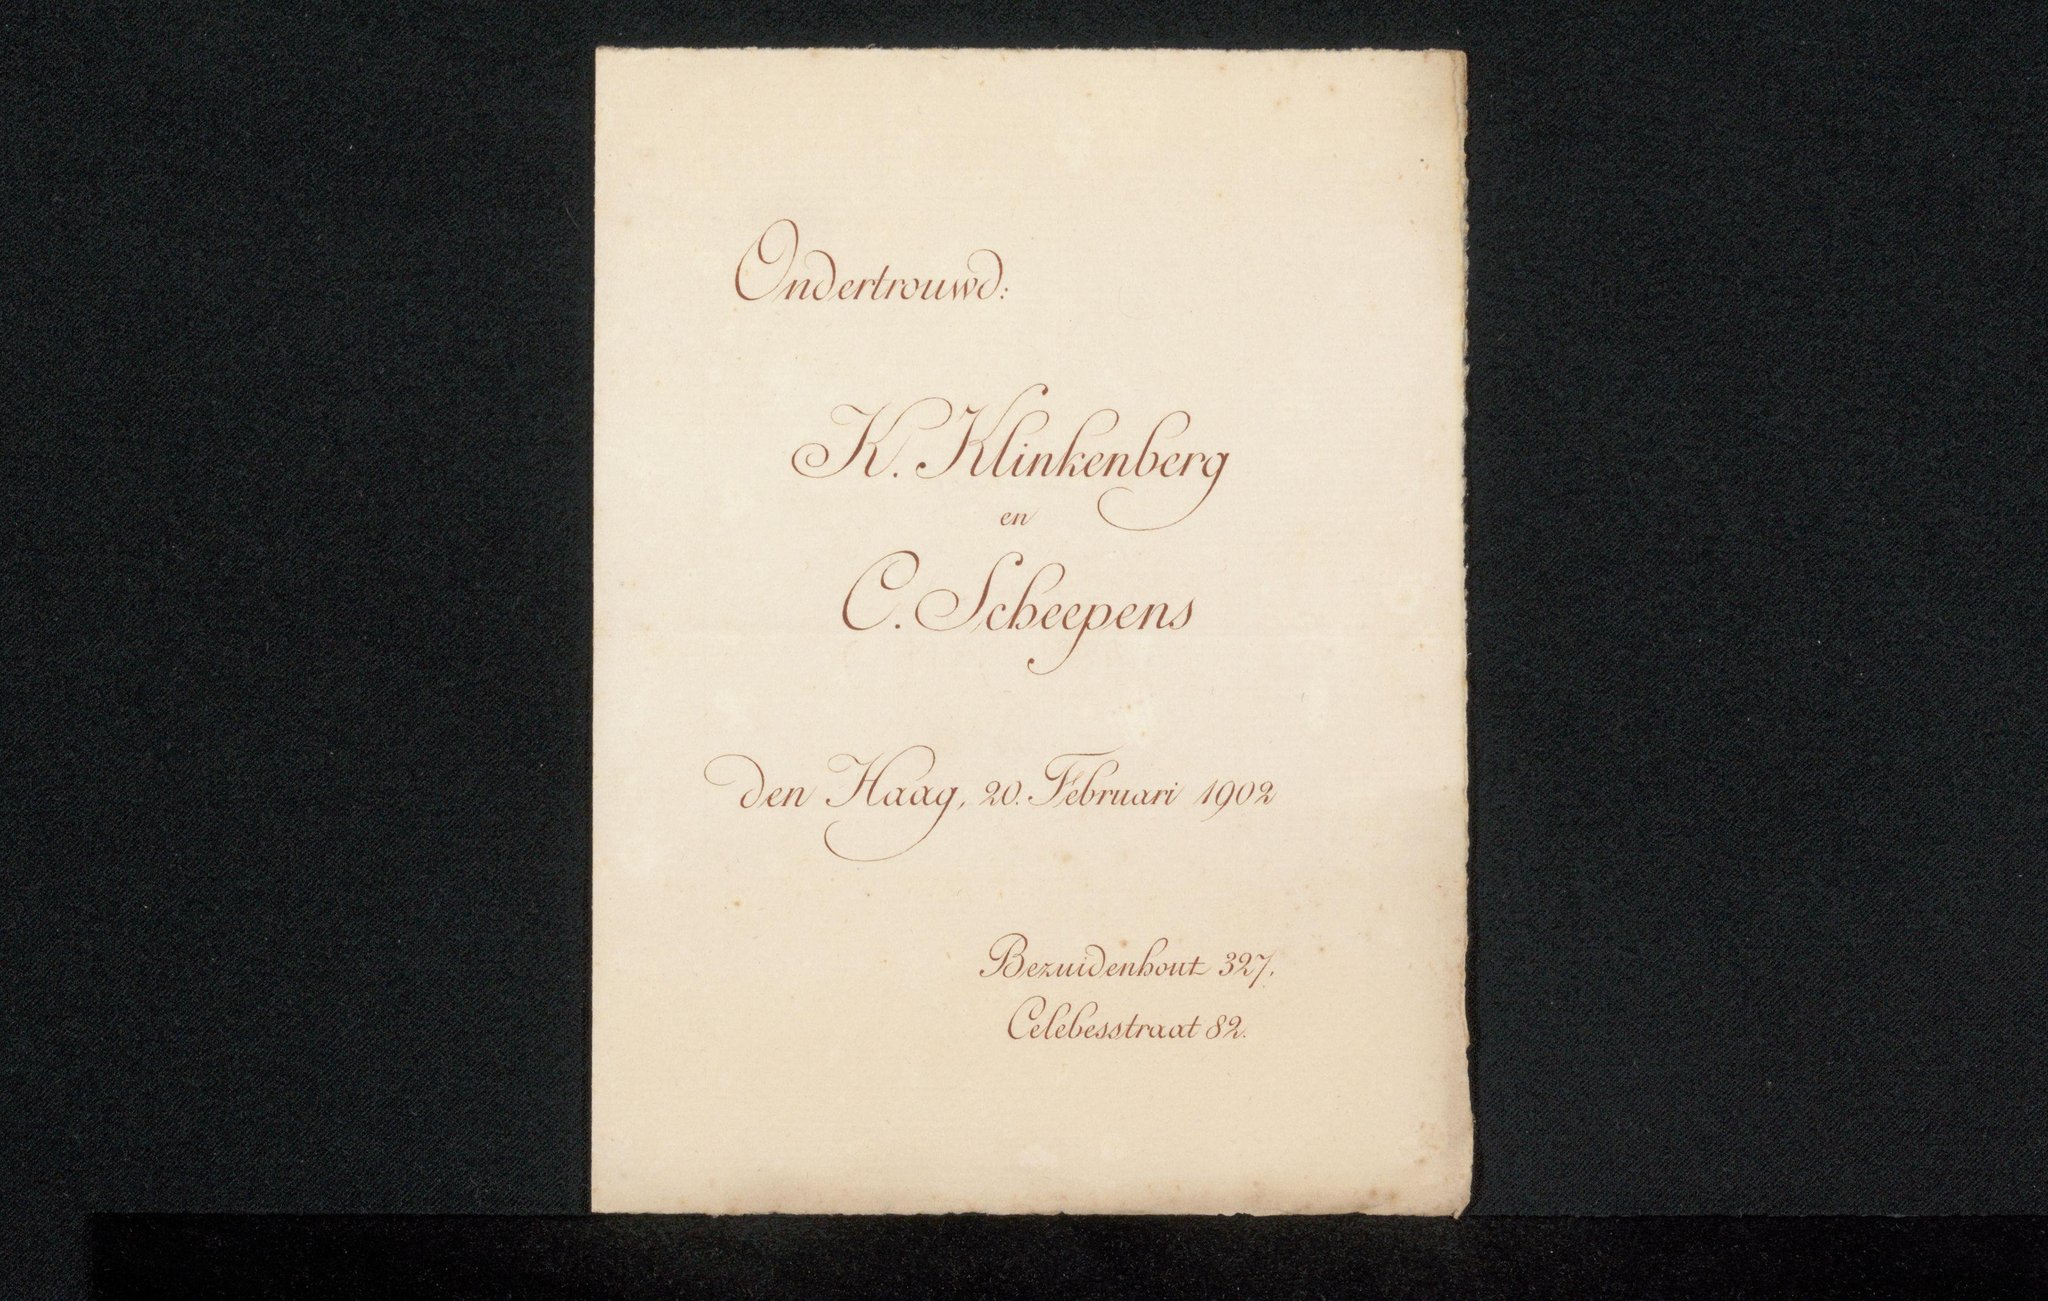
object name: wedding announcement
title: Ondertrouwaankondiging aan Philip Zilcken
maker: Anonymous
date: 1902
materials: paper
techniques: printing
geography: the hague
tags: the hague, painter, draughtsman, johannes christiaan karel klinkenberg, philip zilcken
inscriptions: collector's mark: ‘RPK’